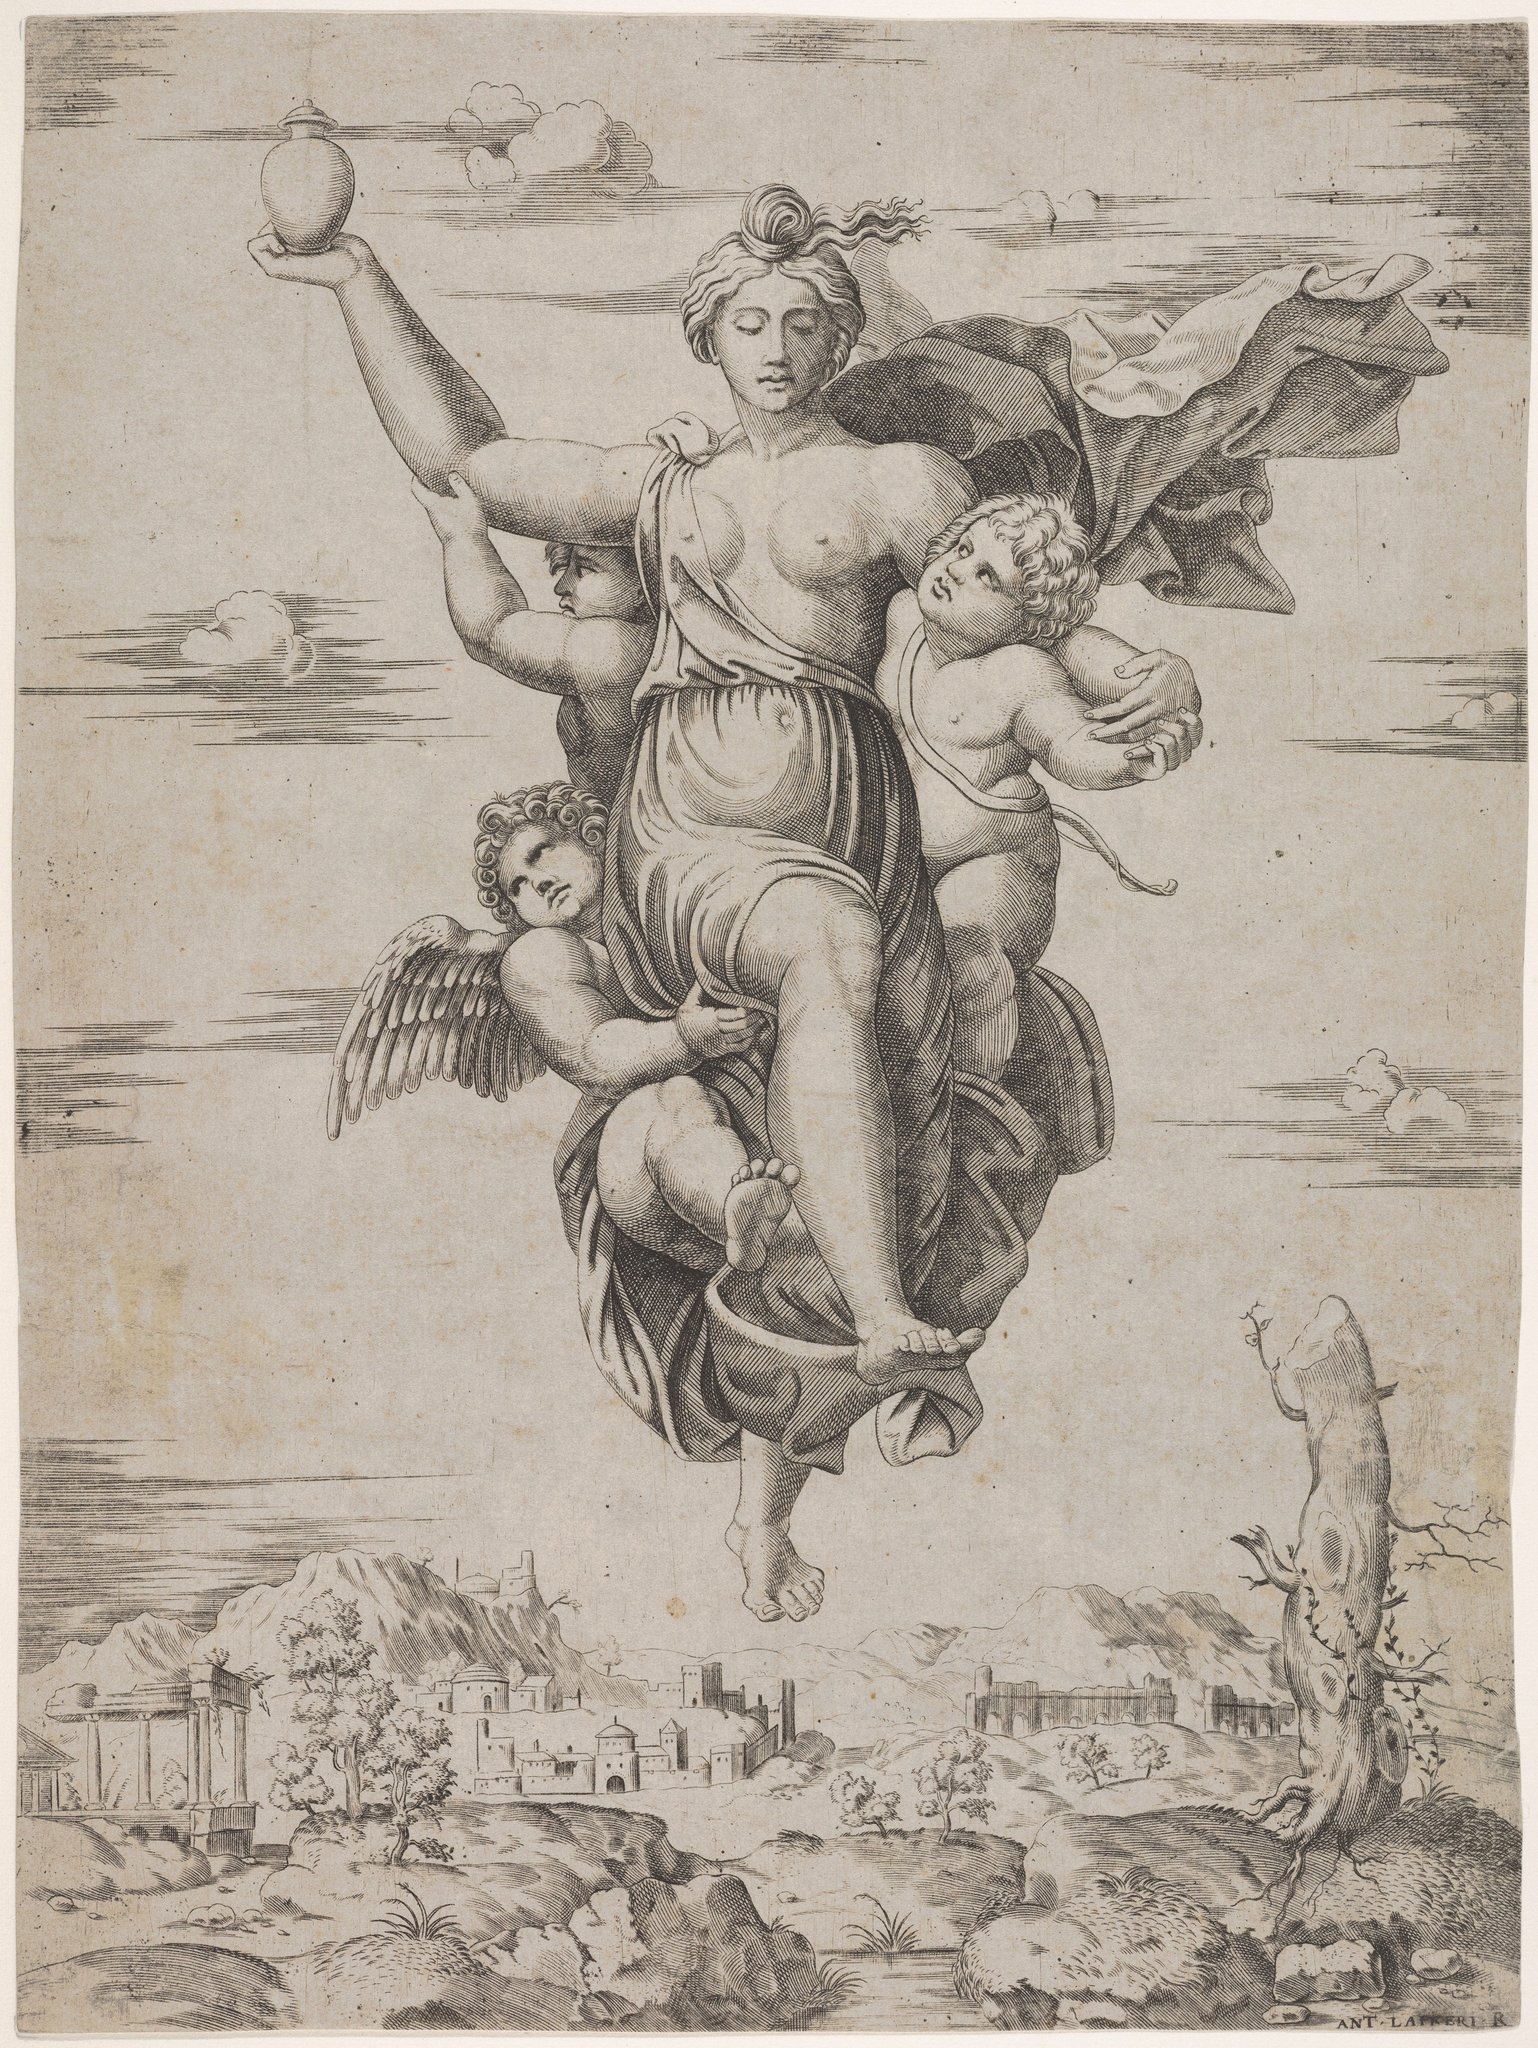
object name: print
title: Psyche Carrying Waters of the Styx (from the Farnesina frescoes)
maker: marcantonio raimondi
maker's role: artist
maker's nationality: italian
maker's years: 1475-1534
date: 1480-1534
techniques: engraving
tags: female nudes,psyche